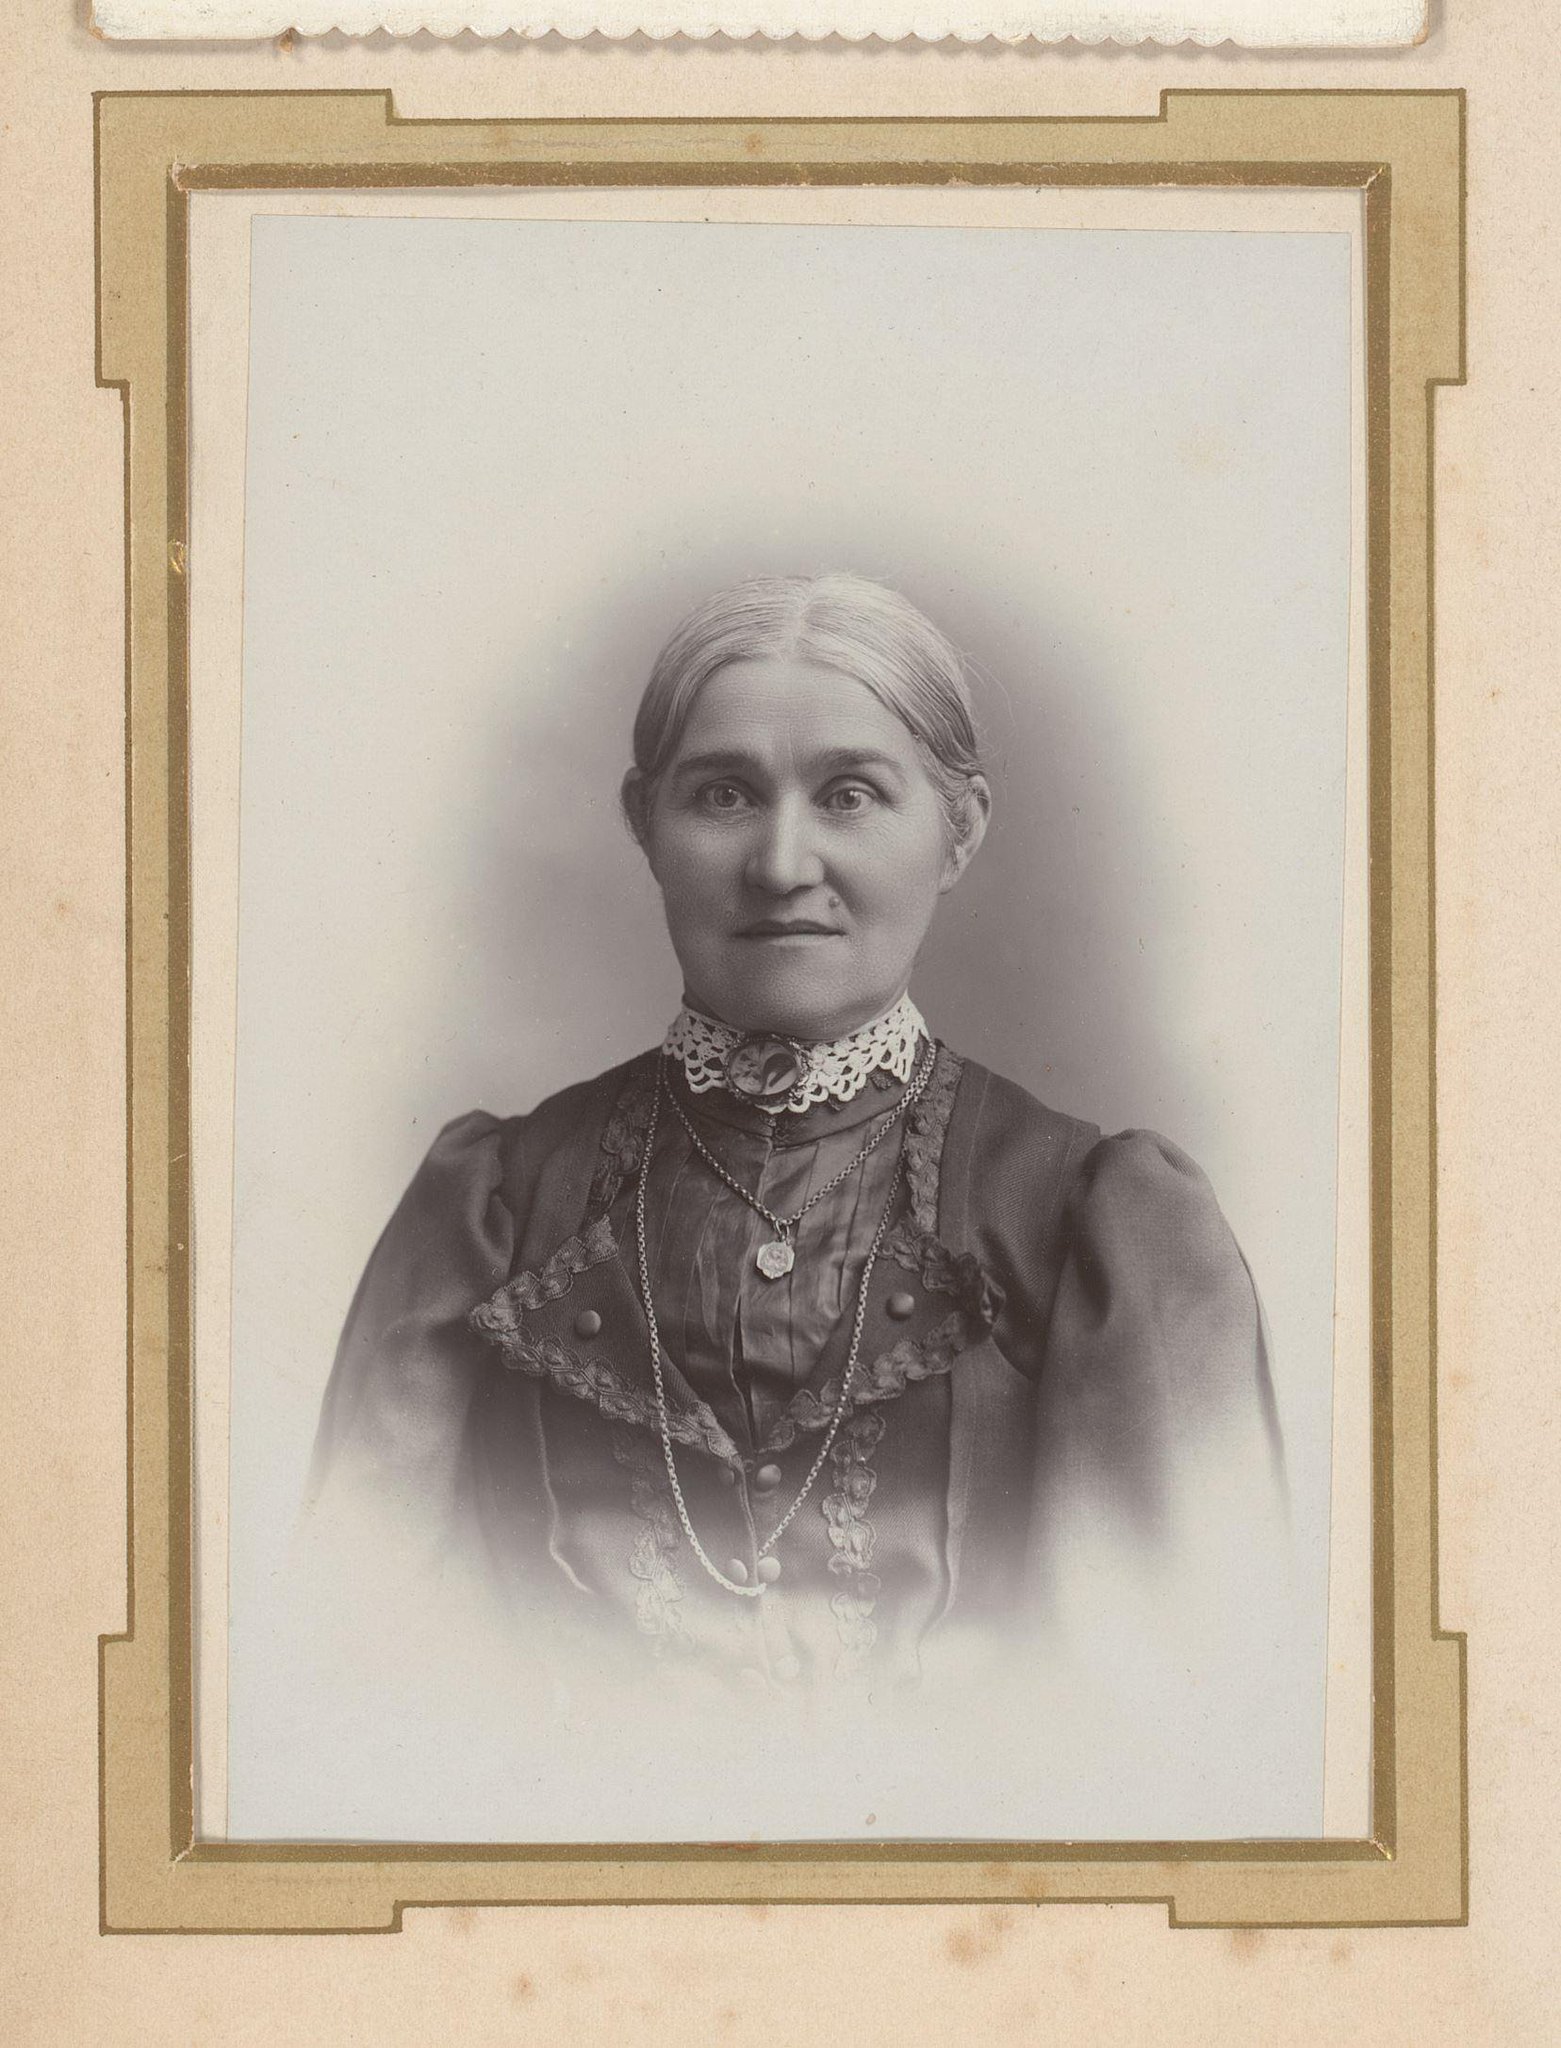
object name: photograph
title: Portret van een vrouw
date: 1880-1920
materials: cardboard, photographic support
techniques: collodion silver print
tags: adult woman, historical persons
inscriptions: inscription: ‘The Northern Phtoto Co/ Successors/ Wesley Place Blaydon/ front street Stanley/ front street Chester le Street/ Ferryhill Station/ Proprietors/ J.J. Dixon/ W. Carrick/ R. Noble’, annotation: ‘8141 Lund/ 5’